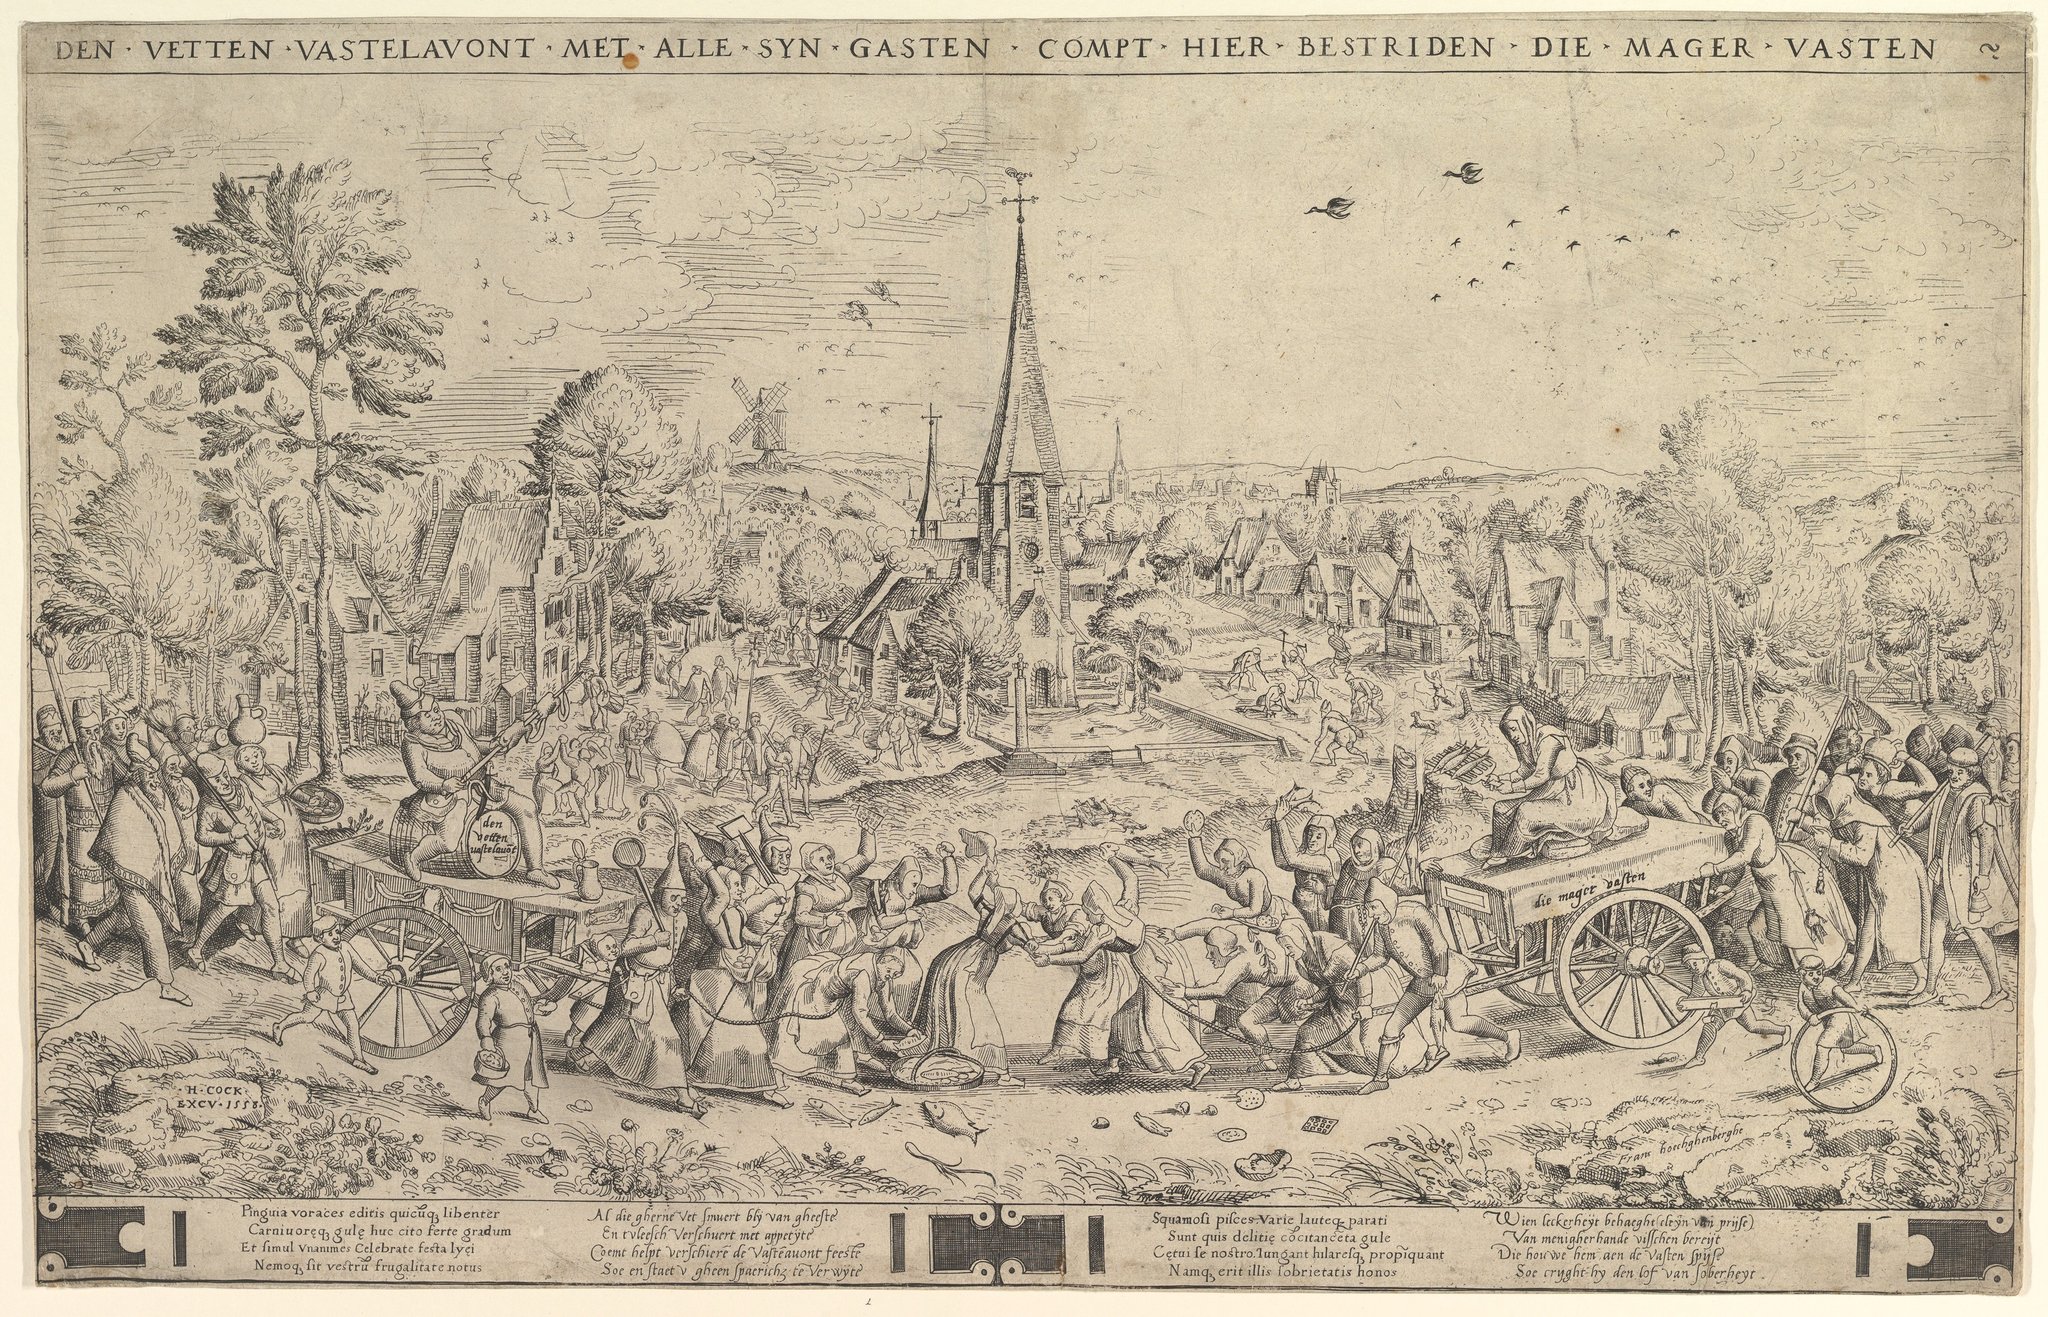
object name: print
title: Lent and Carnival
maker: frans hogenberg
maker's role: artist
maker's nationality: netherlandish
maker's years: 1540-1590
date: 1558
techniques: etching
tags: churches,men,women,fish,trees